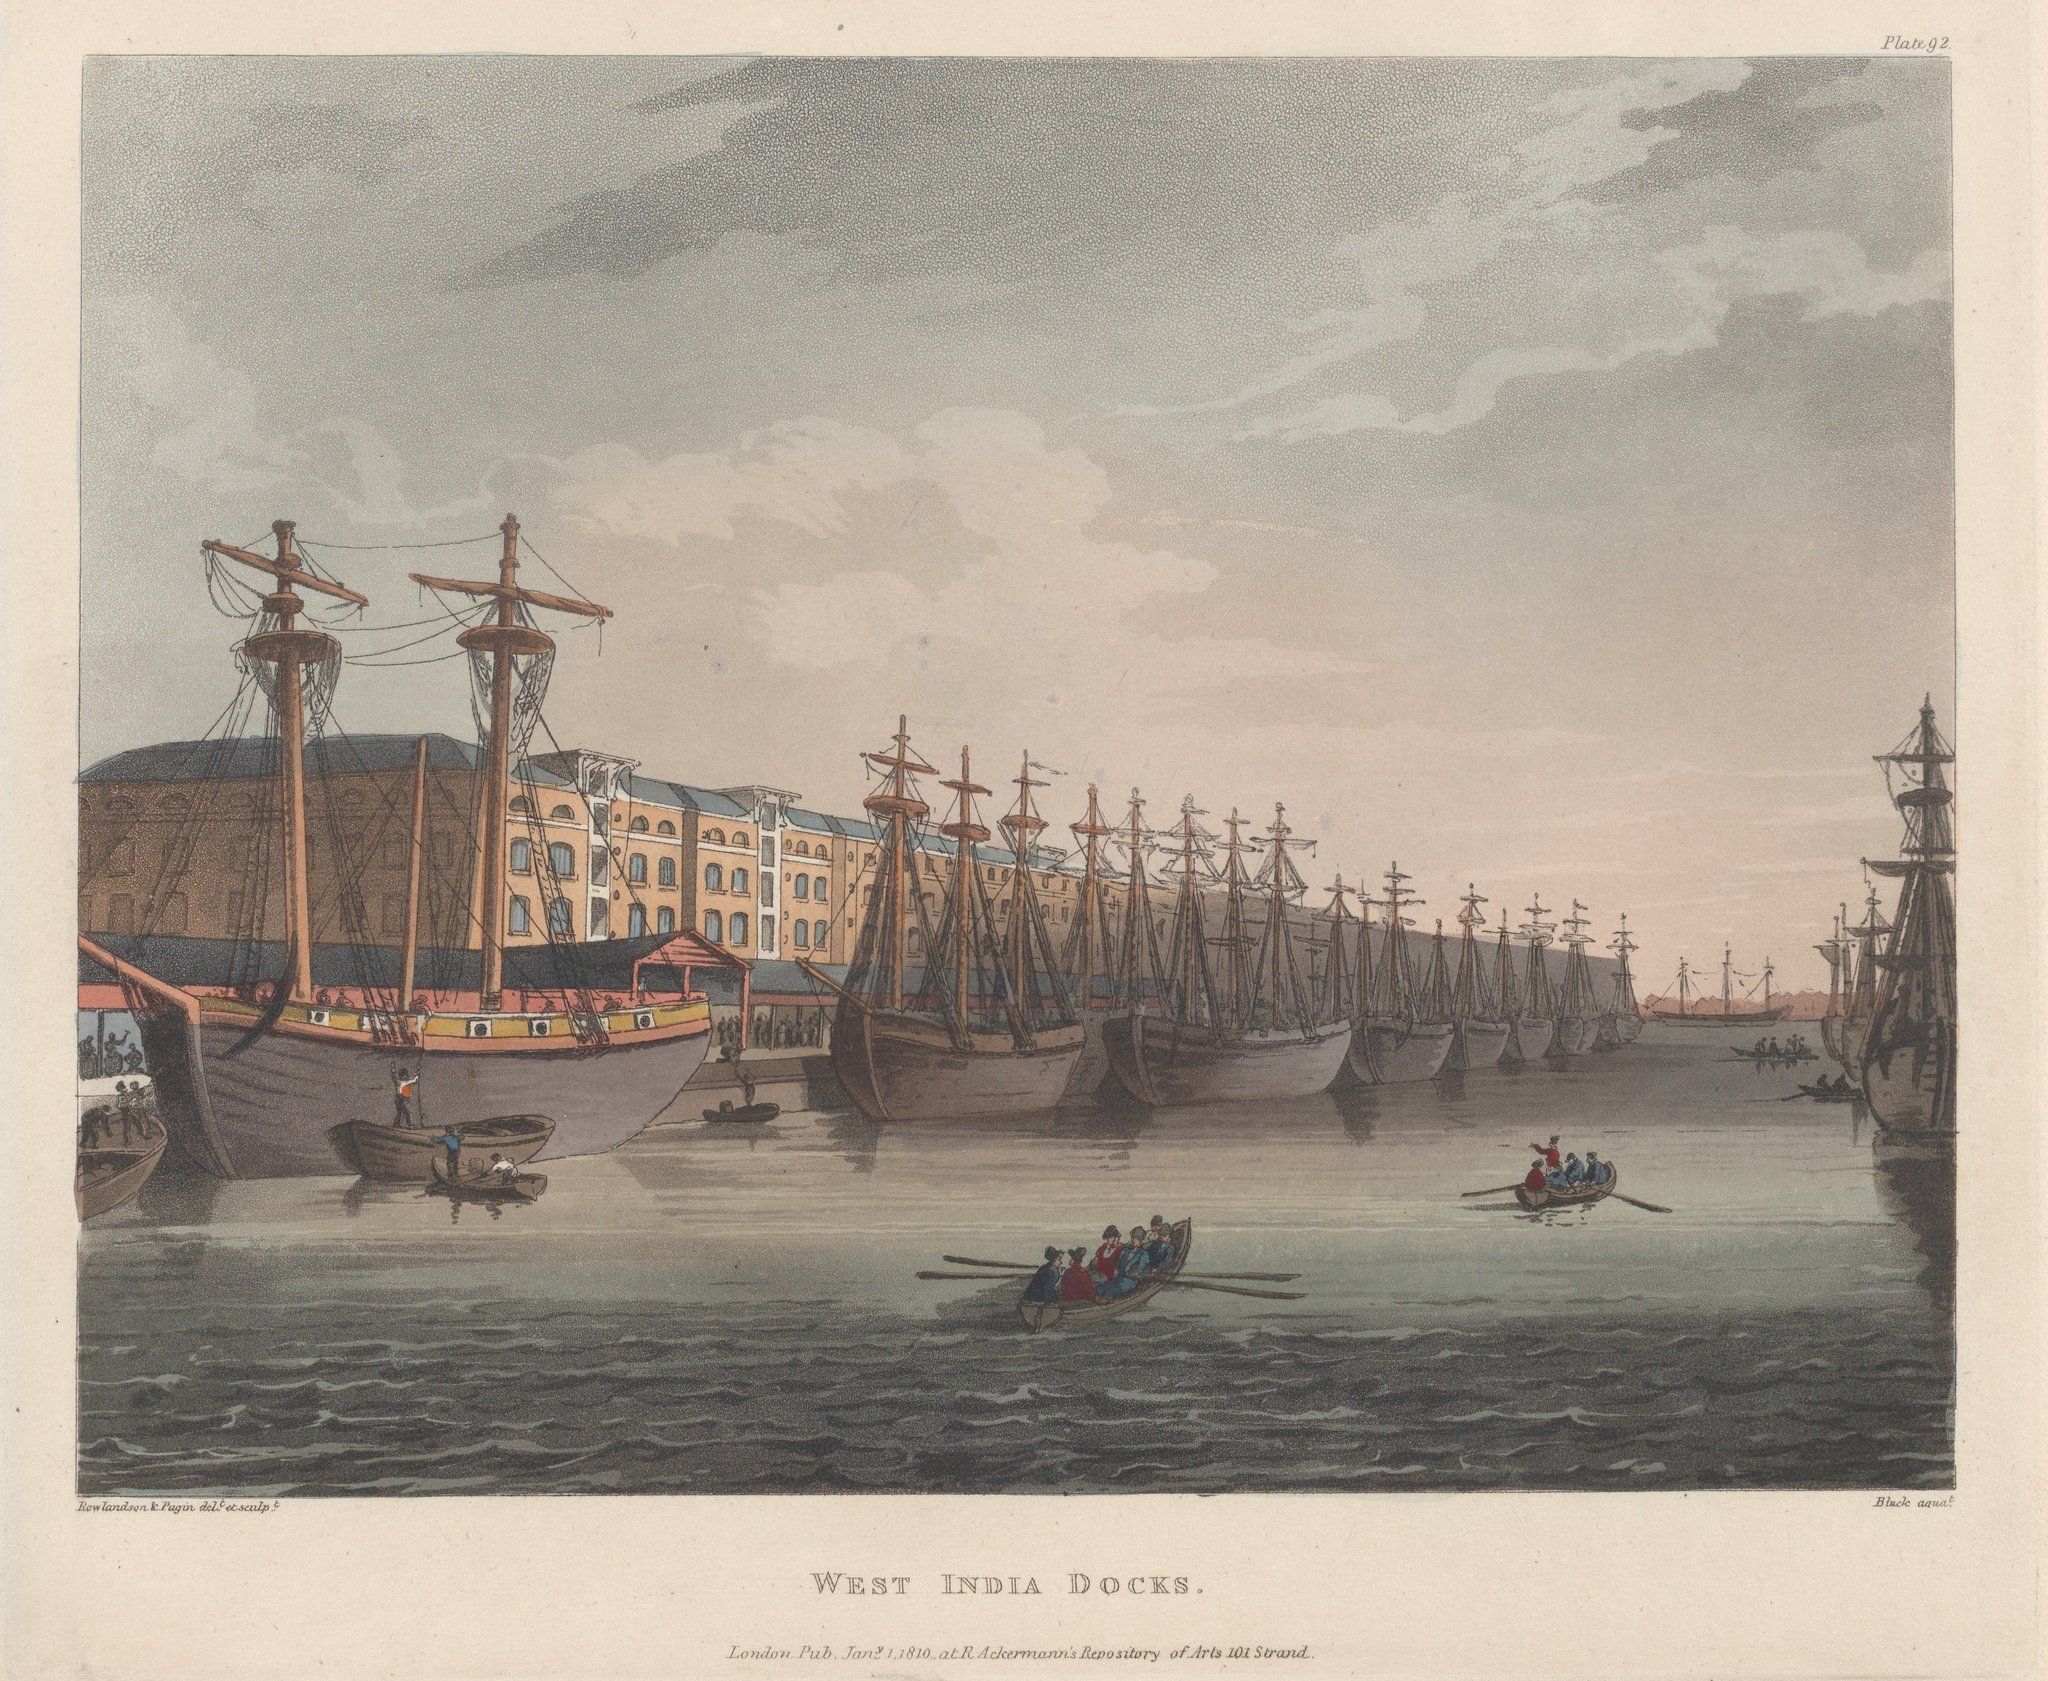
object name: print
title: West India Docks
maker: thomas rowlandson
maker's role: artist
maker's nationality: british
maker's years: 1757-1827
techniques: aquatint, etching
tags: boats,ships,london